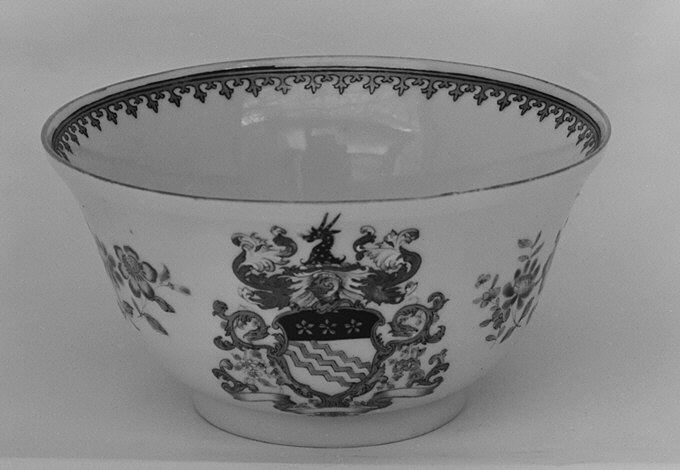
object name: bowl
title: Bowl (part of a service)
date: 1750-1760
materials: hard paste porcelain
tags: coat of arms